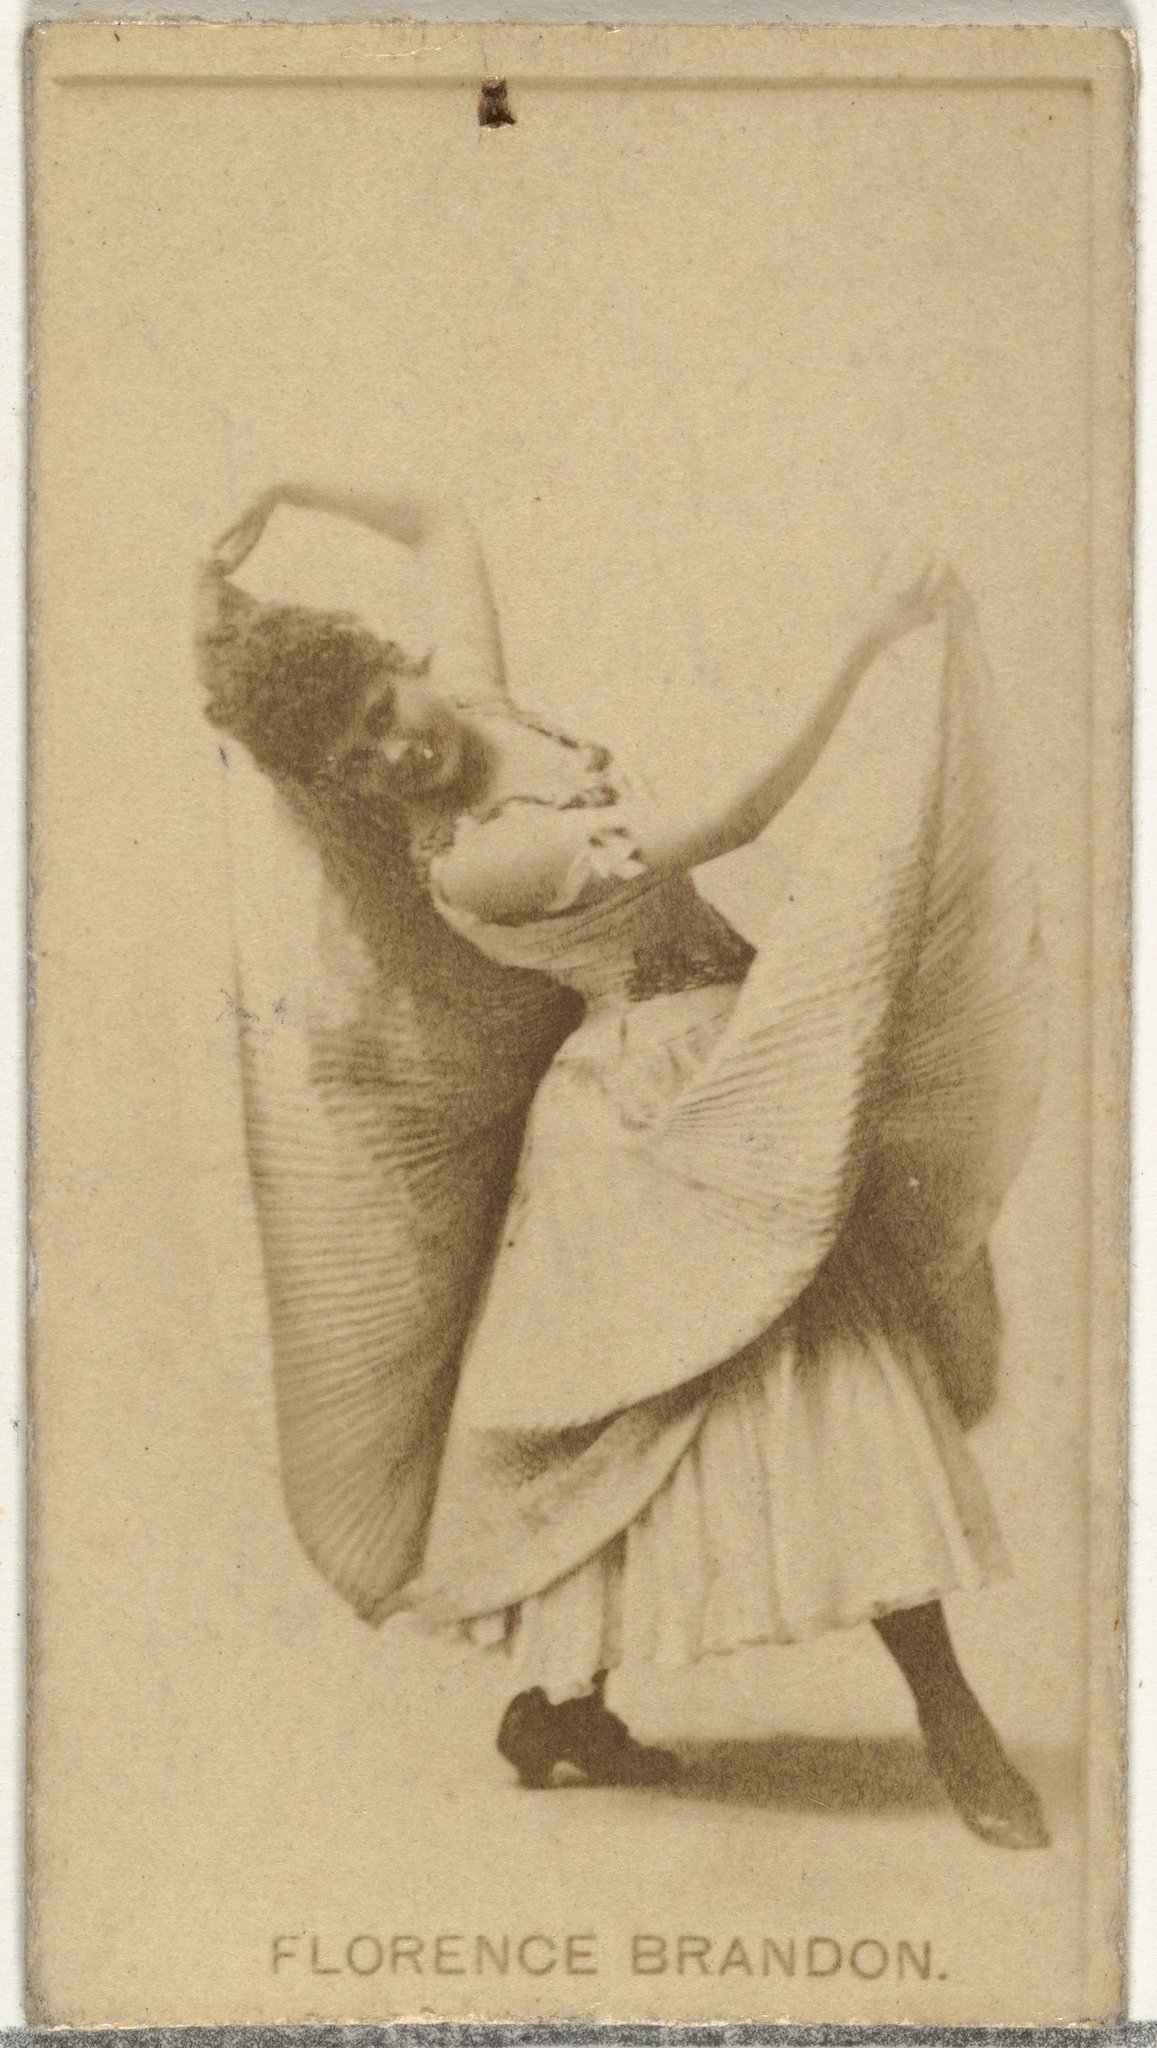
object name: photograph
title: Florence Brandon, from the Actors and Actresses series (N145-8) issued by Duke Sons & Co. to promote Duke Cigarettes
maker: w. duke, sons & co.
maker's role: publisher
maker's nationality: american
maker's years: 1870-1920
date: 1891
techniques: albumen silver print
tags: portraits,women,actresses